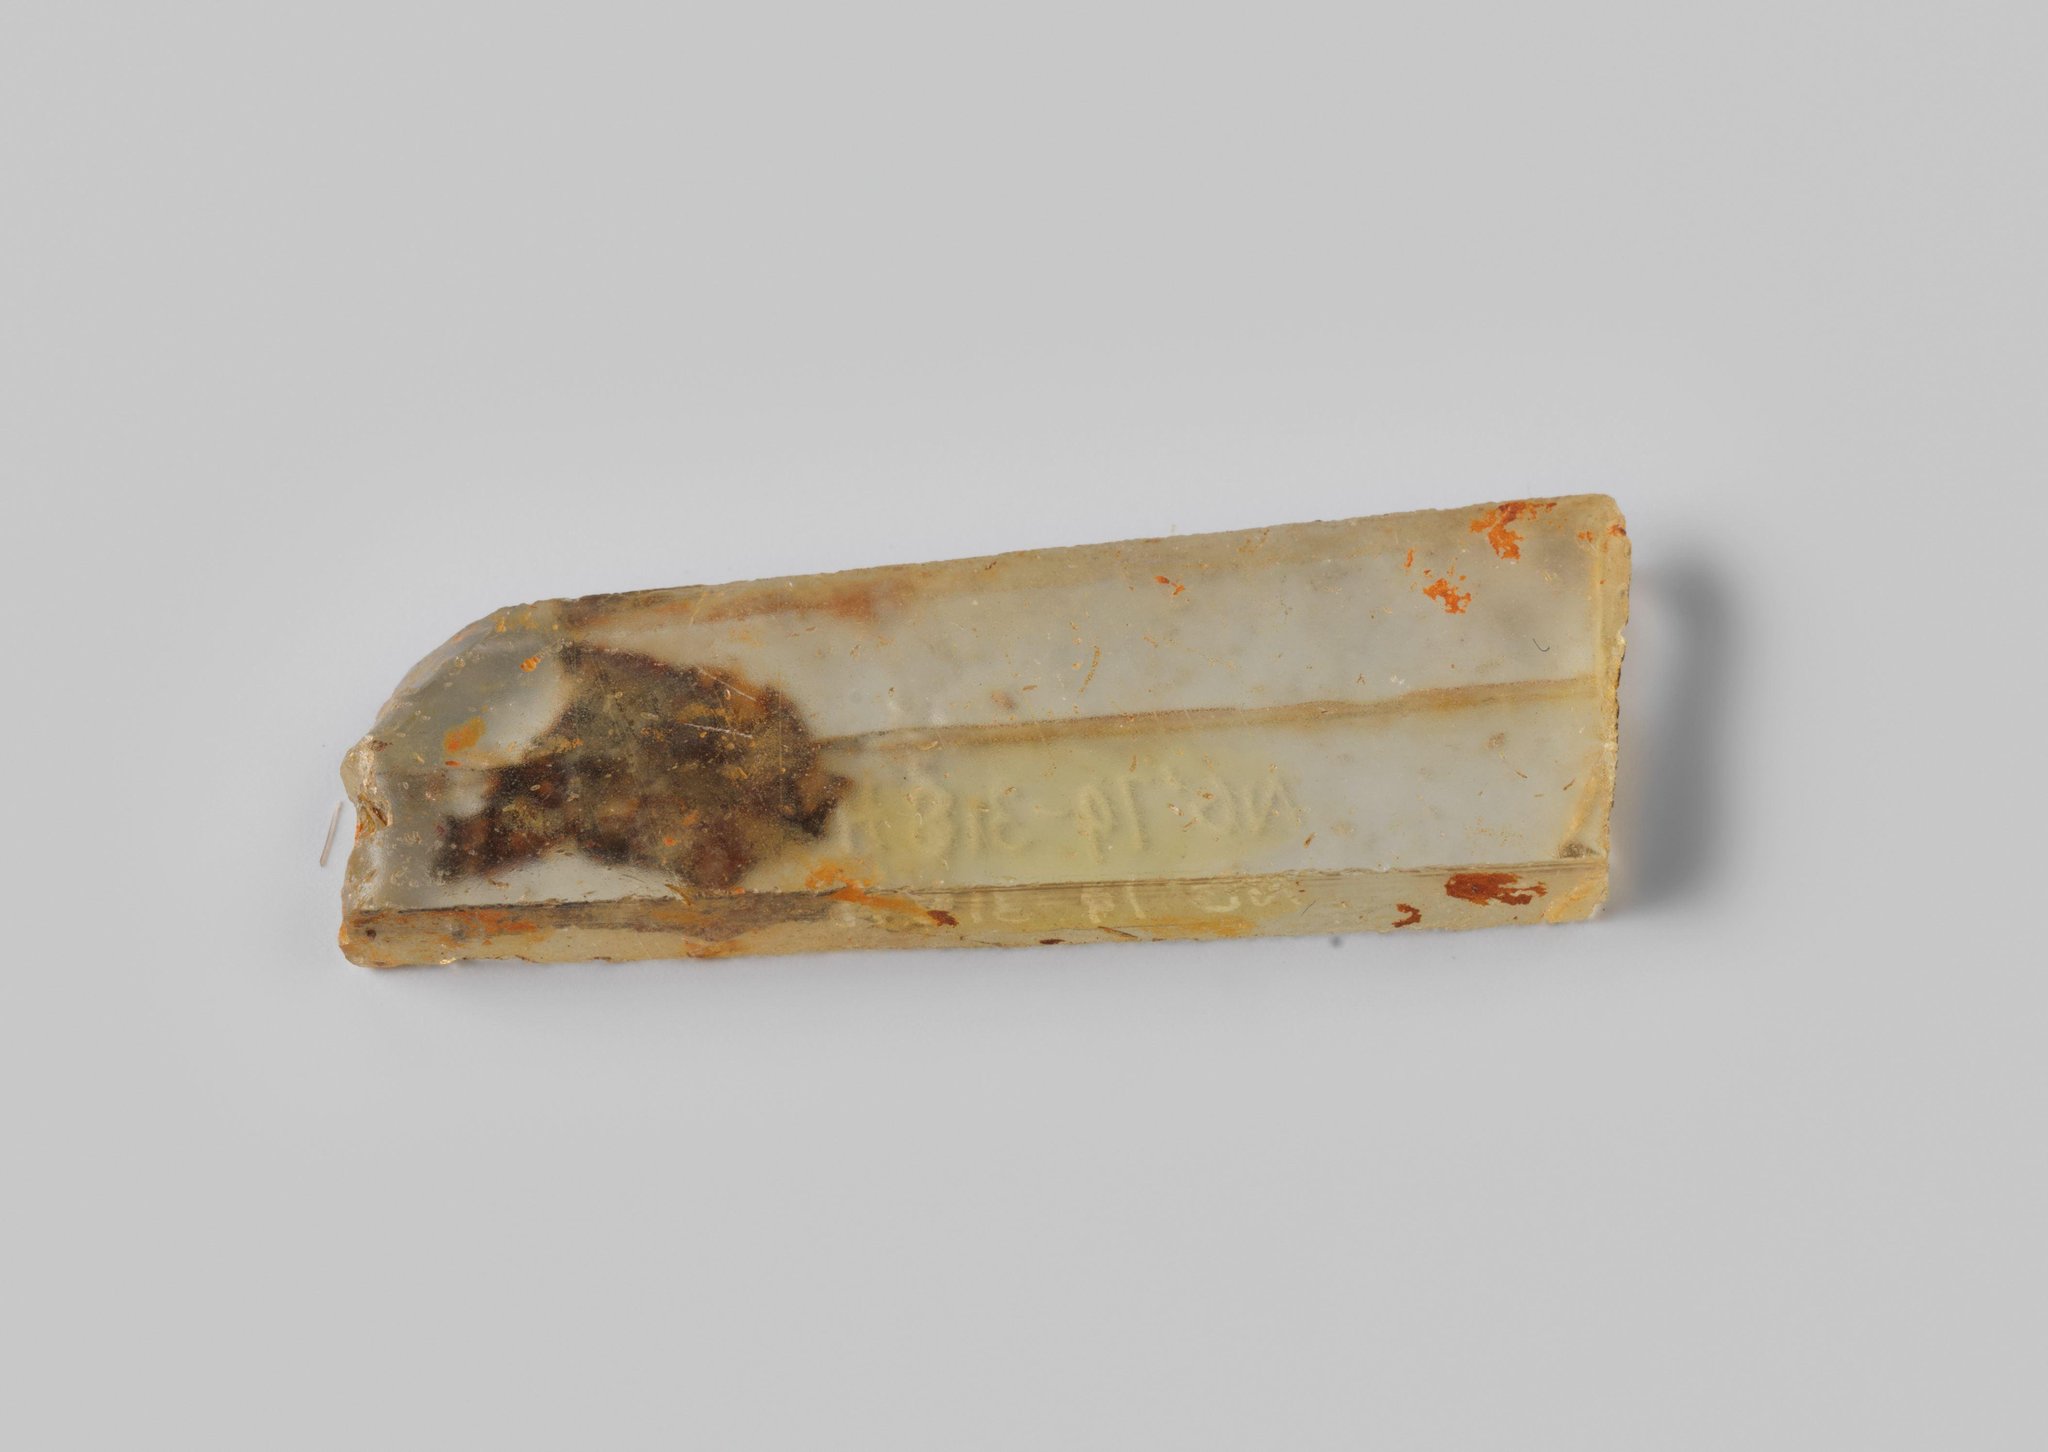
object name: light window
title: Fragment ruit uit het wrak van de Oost-Indiëvaarder Hollandia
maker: Anonymous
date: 1700-1743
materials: glass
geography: netherlands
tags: verenigde oostindische compagnie, hollandia (schip), annet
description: Varied parts or fragments, window glass; fragm, broken, flat.